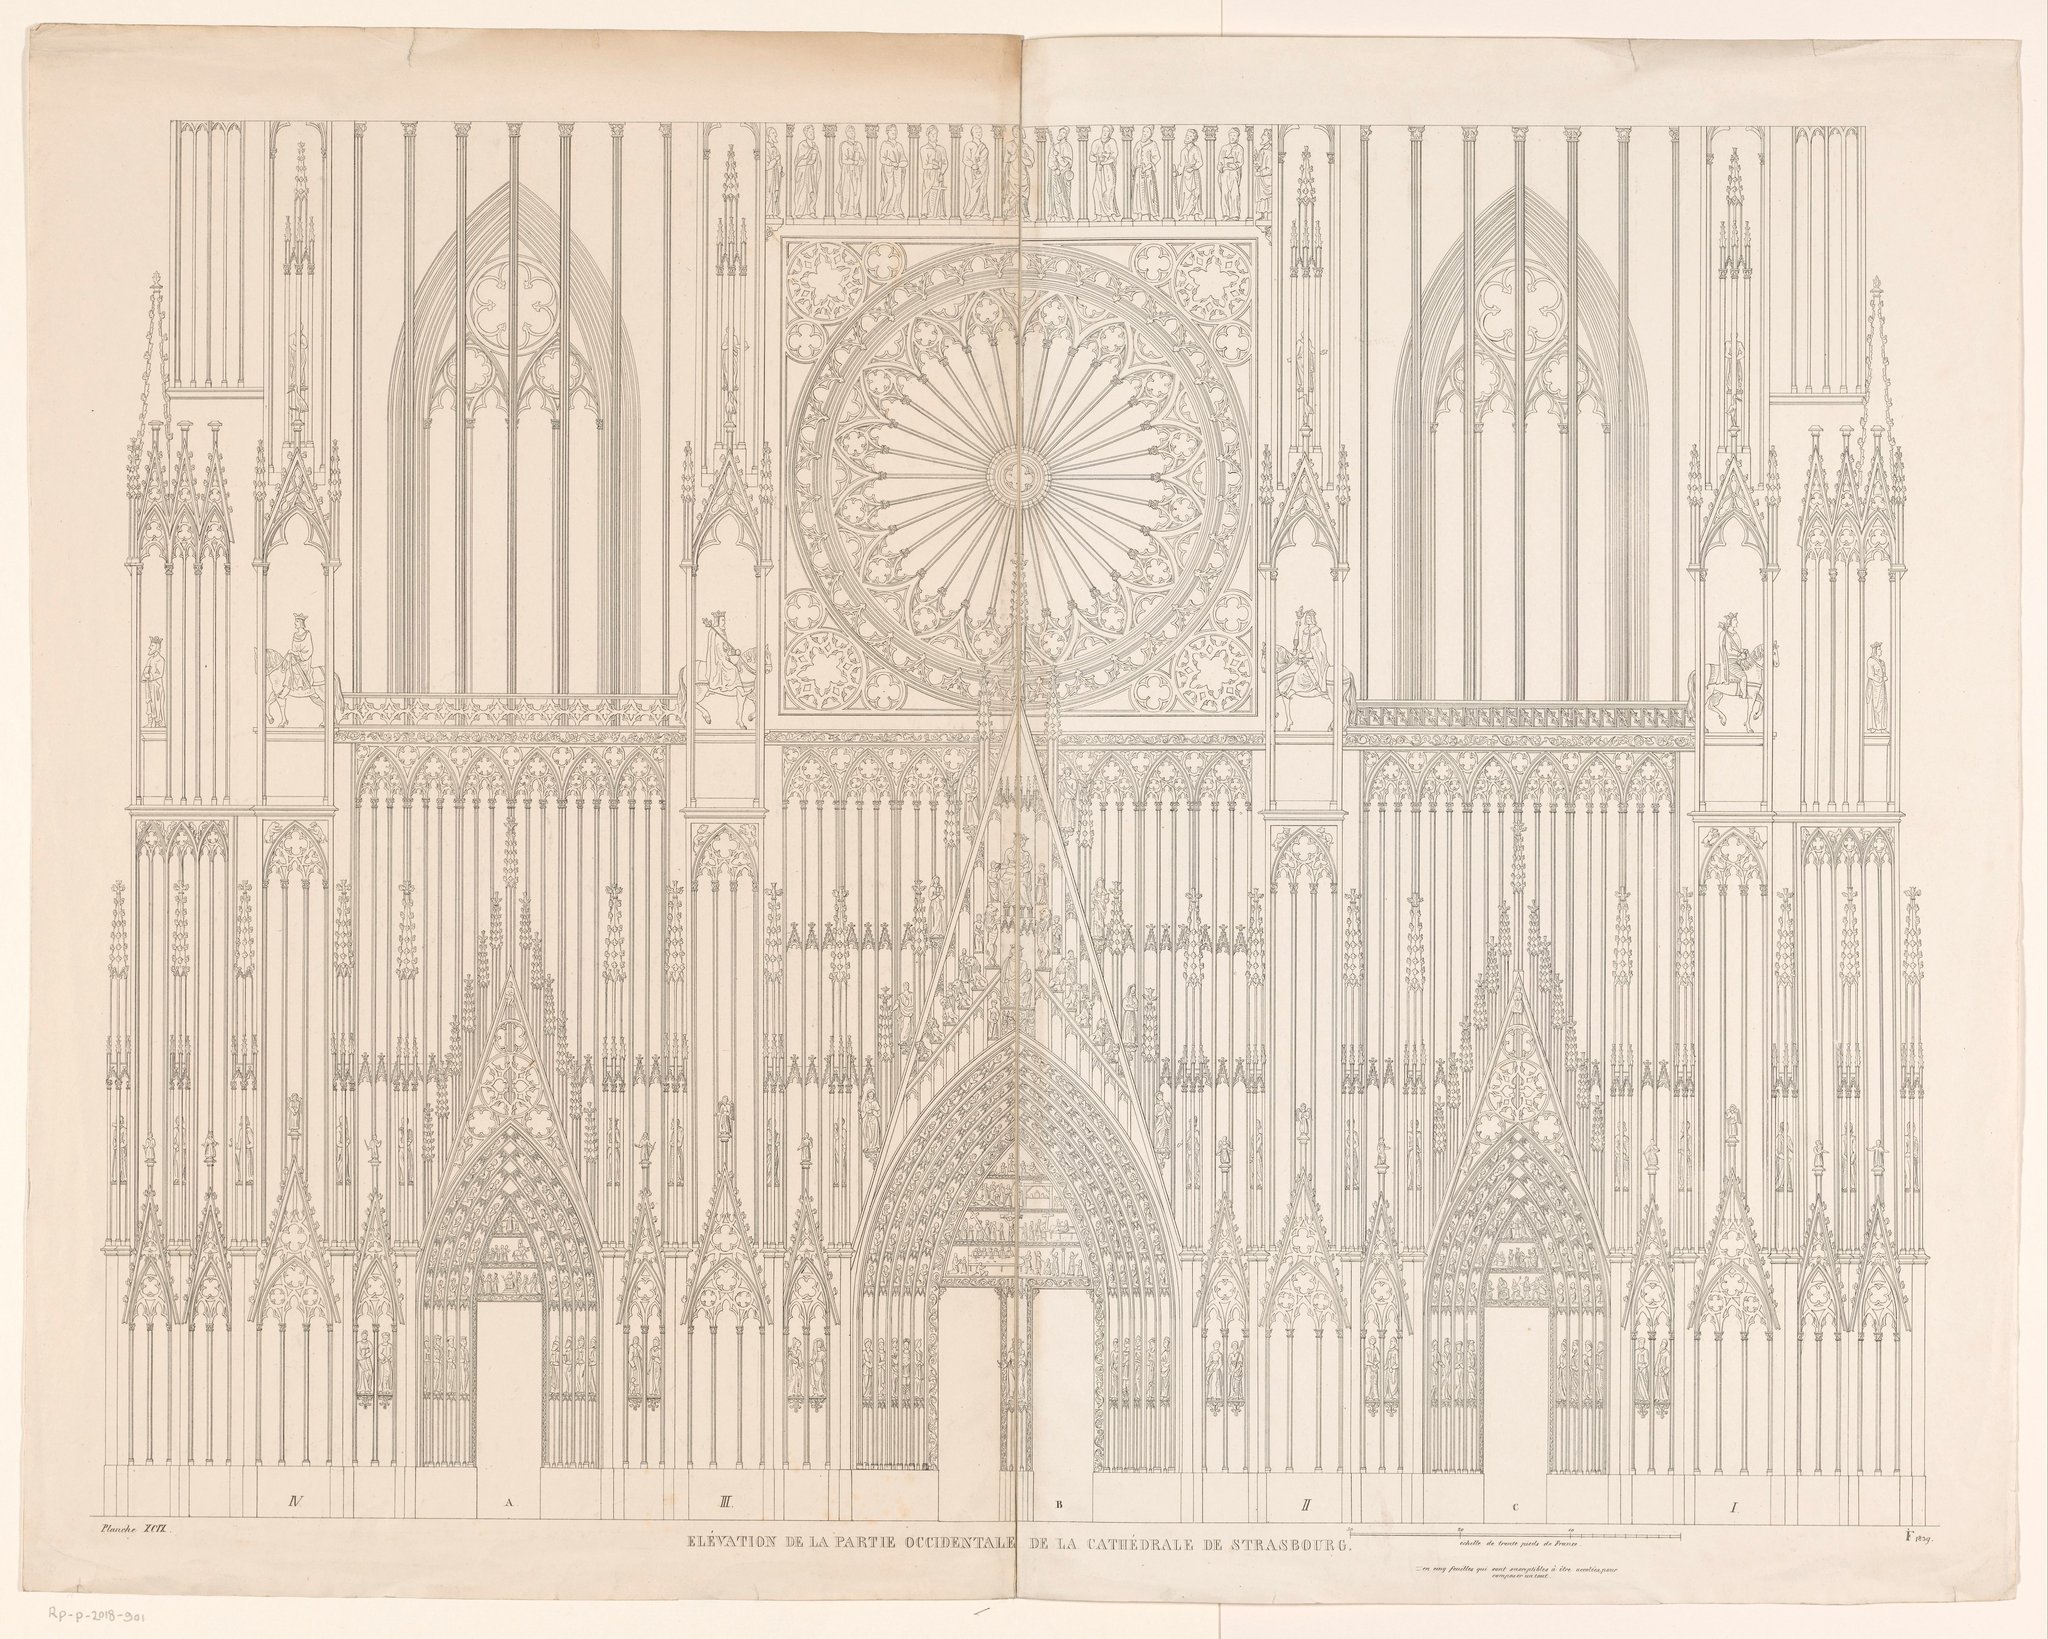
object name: print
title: Elévation de la partie occidentale de la cathédrale de Strasbourg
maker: Anonymous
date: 1839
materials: paper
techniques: engraving, etching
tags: church (exterior)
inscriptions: collector's mark: Lugt 2228